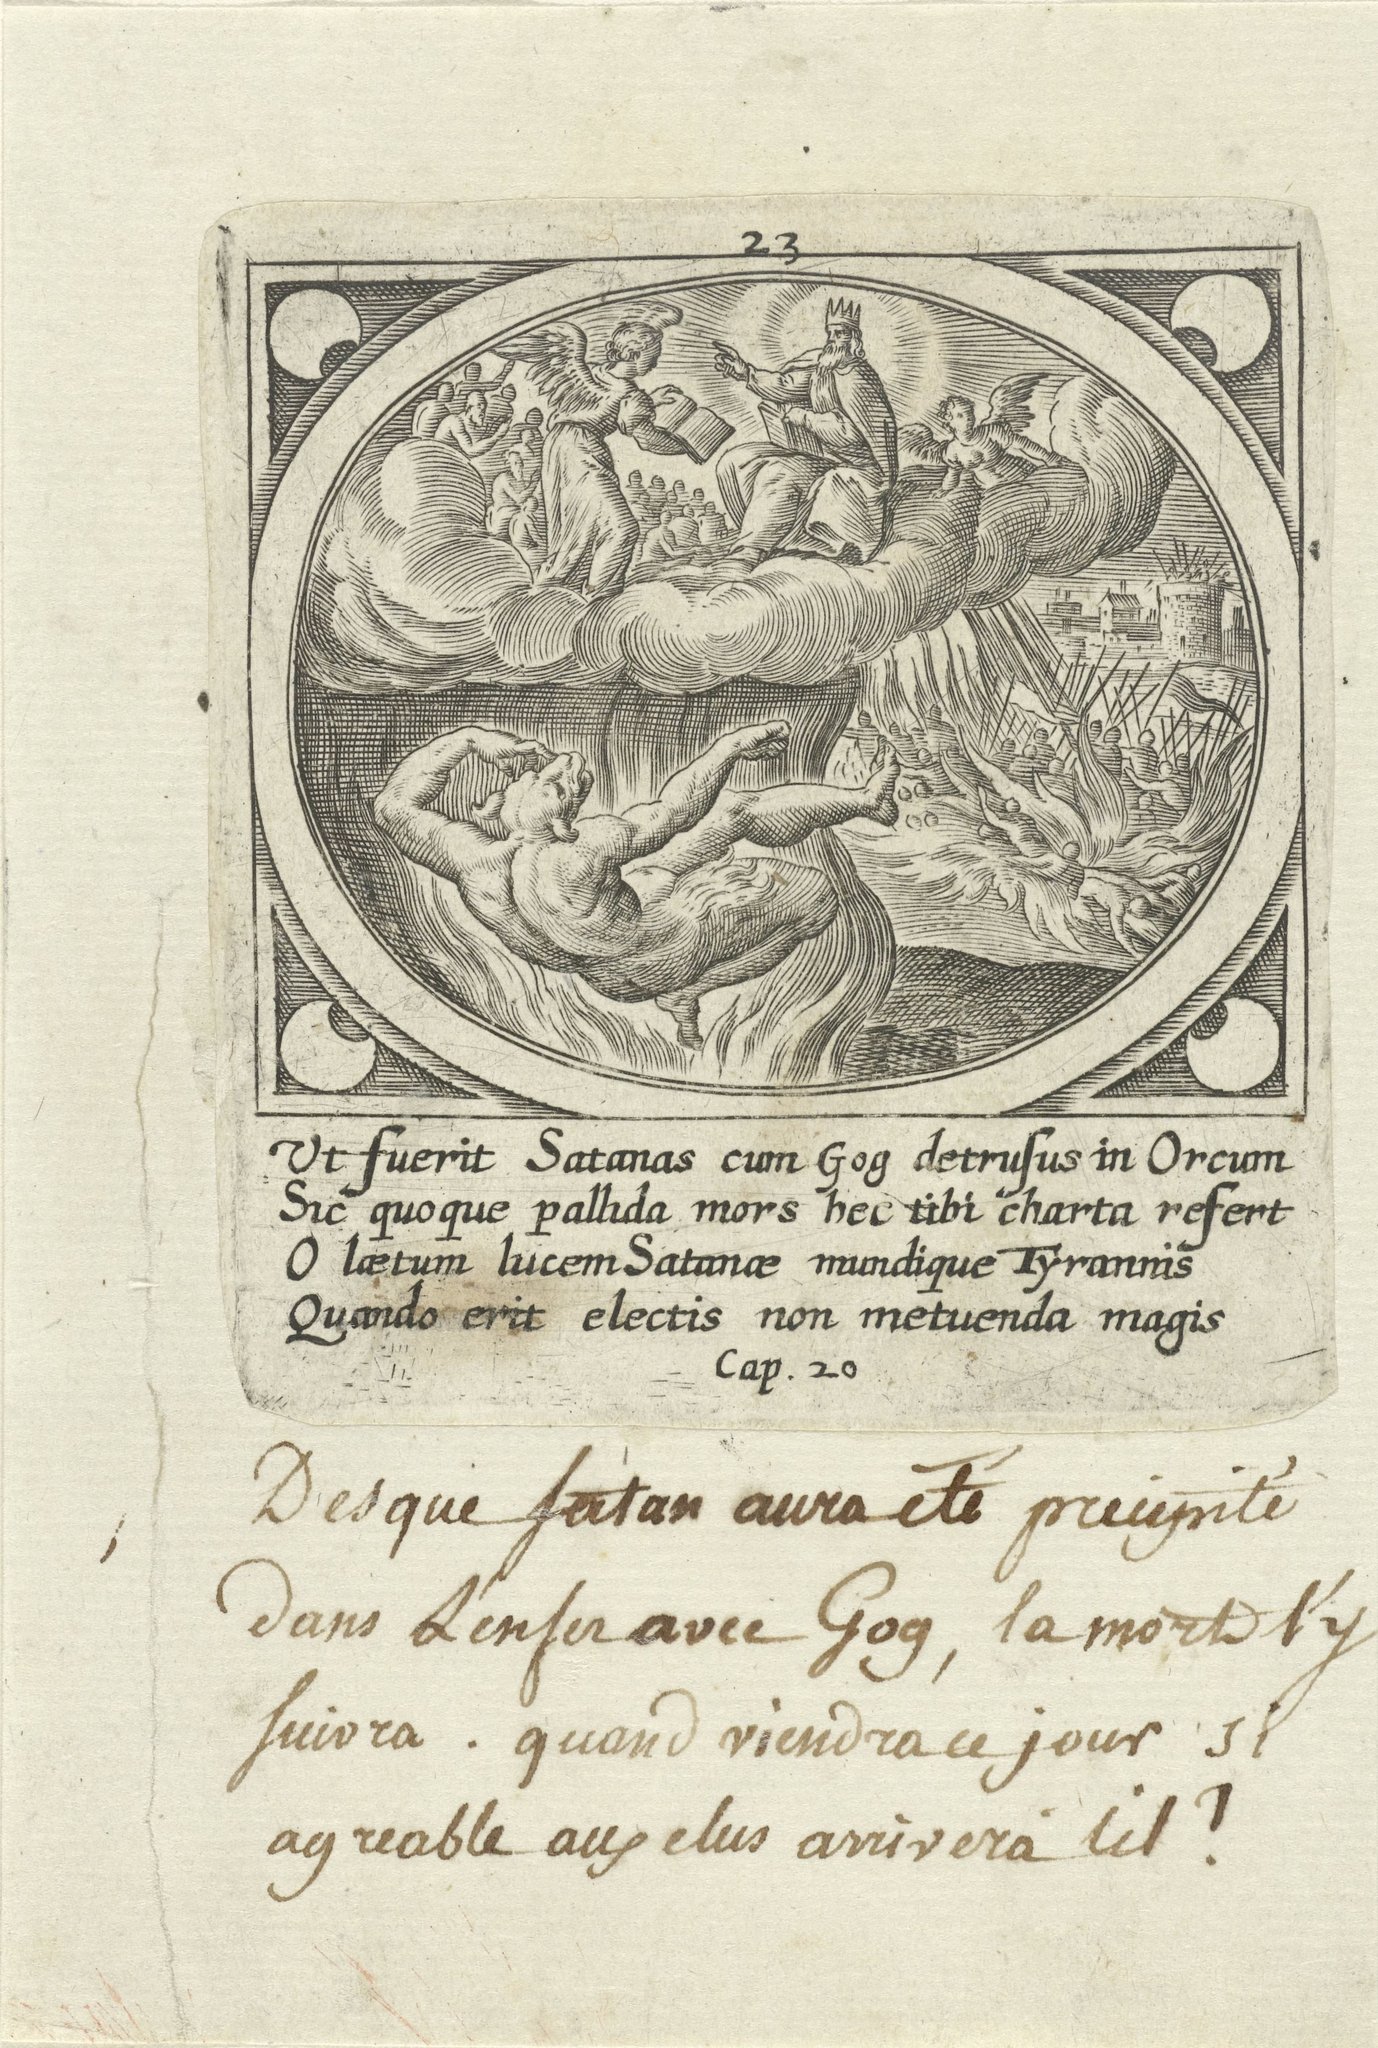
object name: print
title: Icones Revelationum S Johs Evangeliste in Pathmo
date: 1585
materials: paper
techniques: engraving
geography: antwerp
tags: fire from heaven devours satan, gog and magog, and satan is cast into a lake of fire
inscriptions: inscription: ‘Desque satan [...] arrivera lit?’, collector's mark: Lugt 2228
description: Hemel met God de Vader, zittend op troon, omringd door doden. Tegenover hem staat een engel met een open boek. Op de achtergrond wordt iedereen die niet in het boek van het leven blijkt te staan in de vuurpoel gegooid (de tweede dood). De duivel, na duizend jaar weer bevrijd, wordt in de poel van vuur en zwavel geworpen. In de marge een vierregelig onderschrift in het Latijn. Drieëntwintigste prent uit een serie van vierentwintig met de openbaring van Johannes op Patmos.